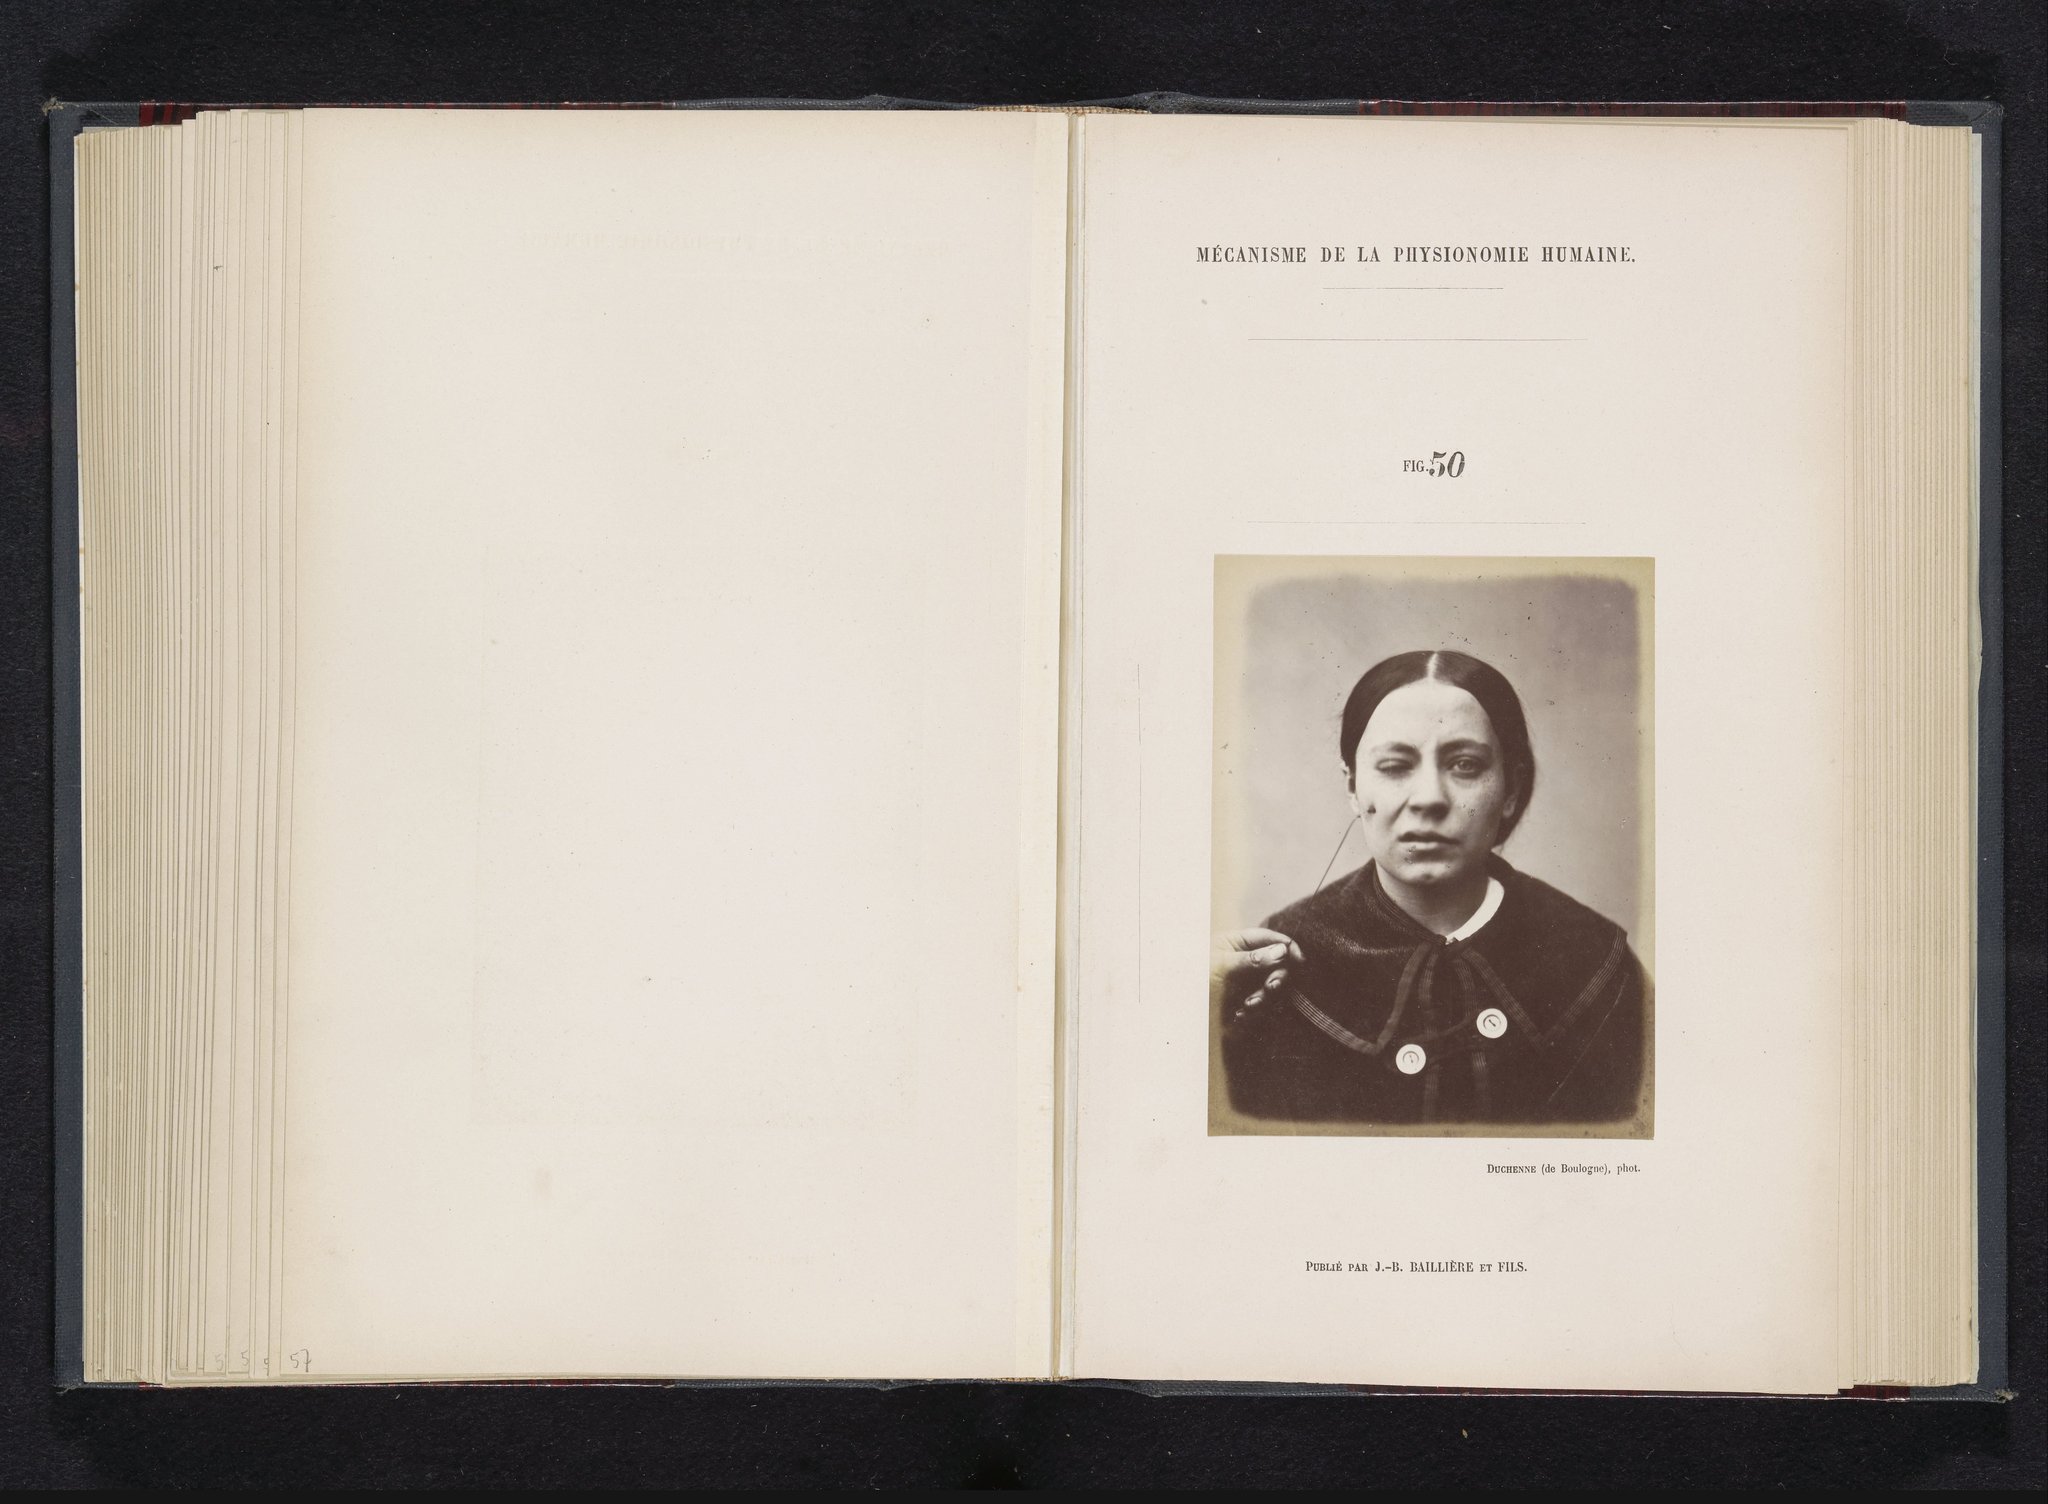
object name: page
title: Portret van een proefpersoon tijdens elektrostimulatie: 'une jeune femme'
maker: guillaume benjamin amand duchenne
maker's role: fotograaf, medicus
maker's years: 1806-1875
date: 1860-1862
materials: paper, photographic support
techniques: albumen print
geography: paris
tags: face, adult woman, physiology and anatomy ~ nervous system, neurology, physiology and anatomy, morphology of facial expression, physiognomy, experiment, test ~ science and technology, france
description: Ongenummerde pagina met foto 50 uit Mécanisme de la physionomie humaine ou analyse électro-physiologique de l'expression des passions (Atlas).